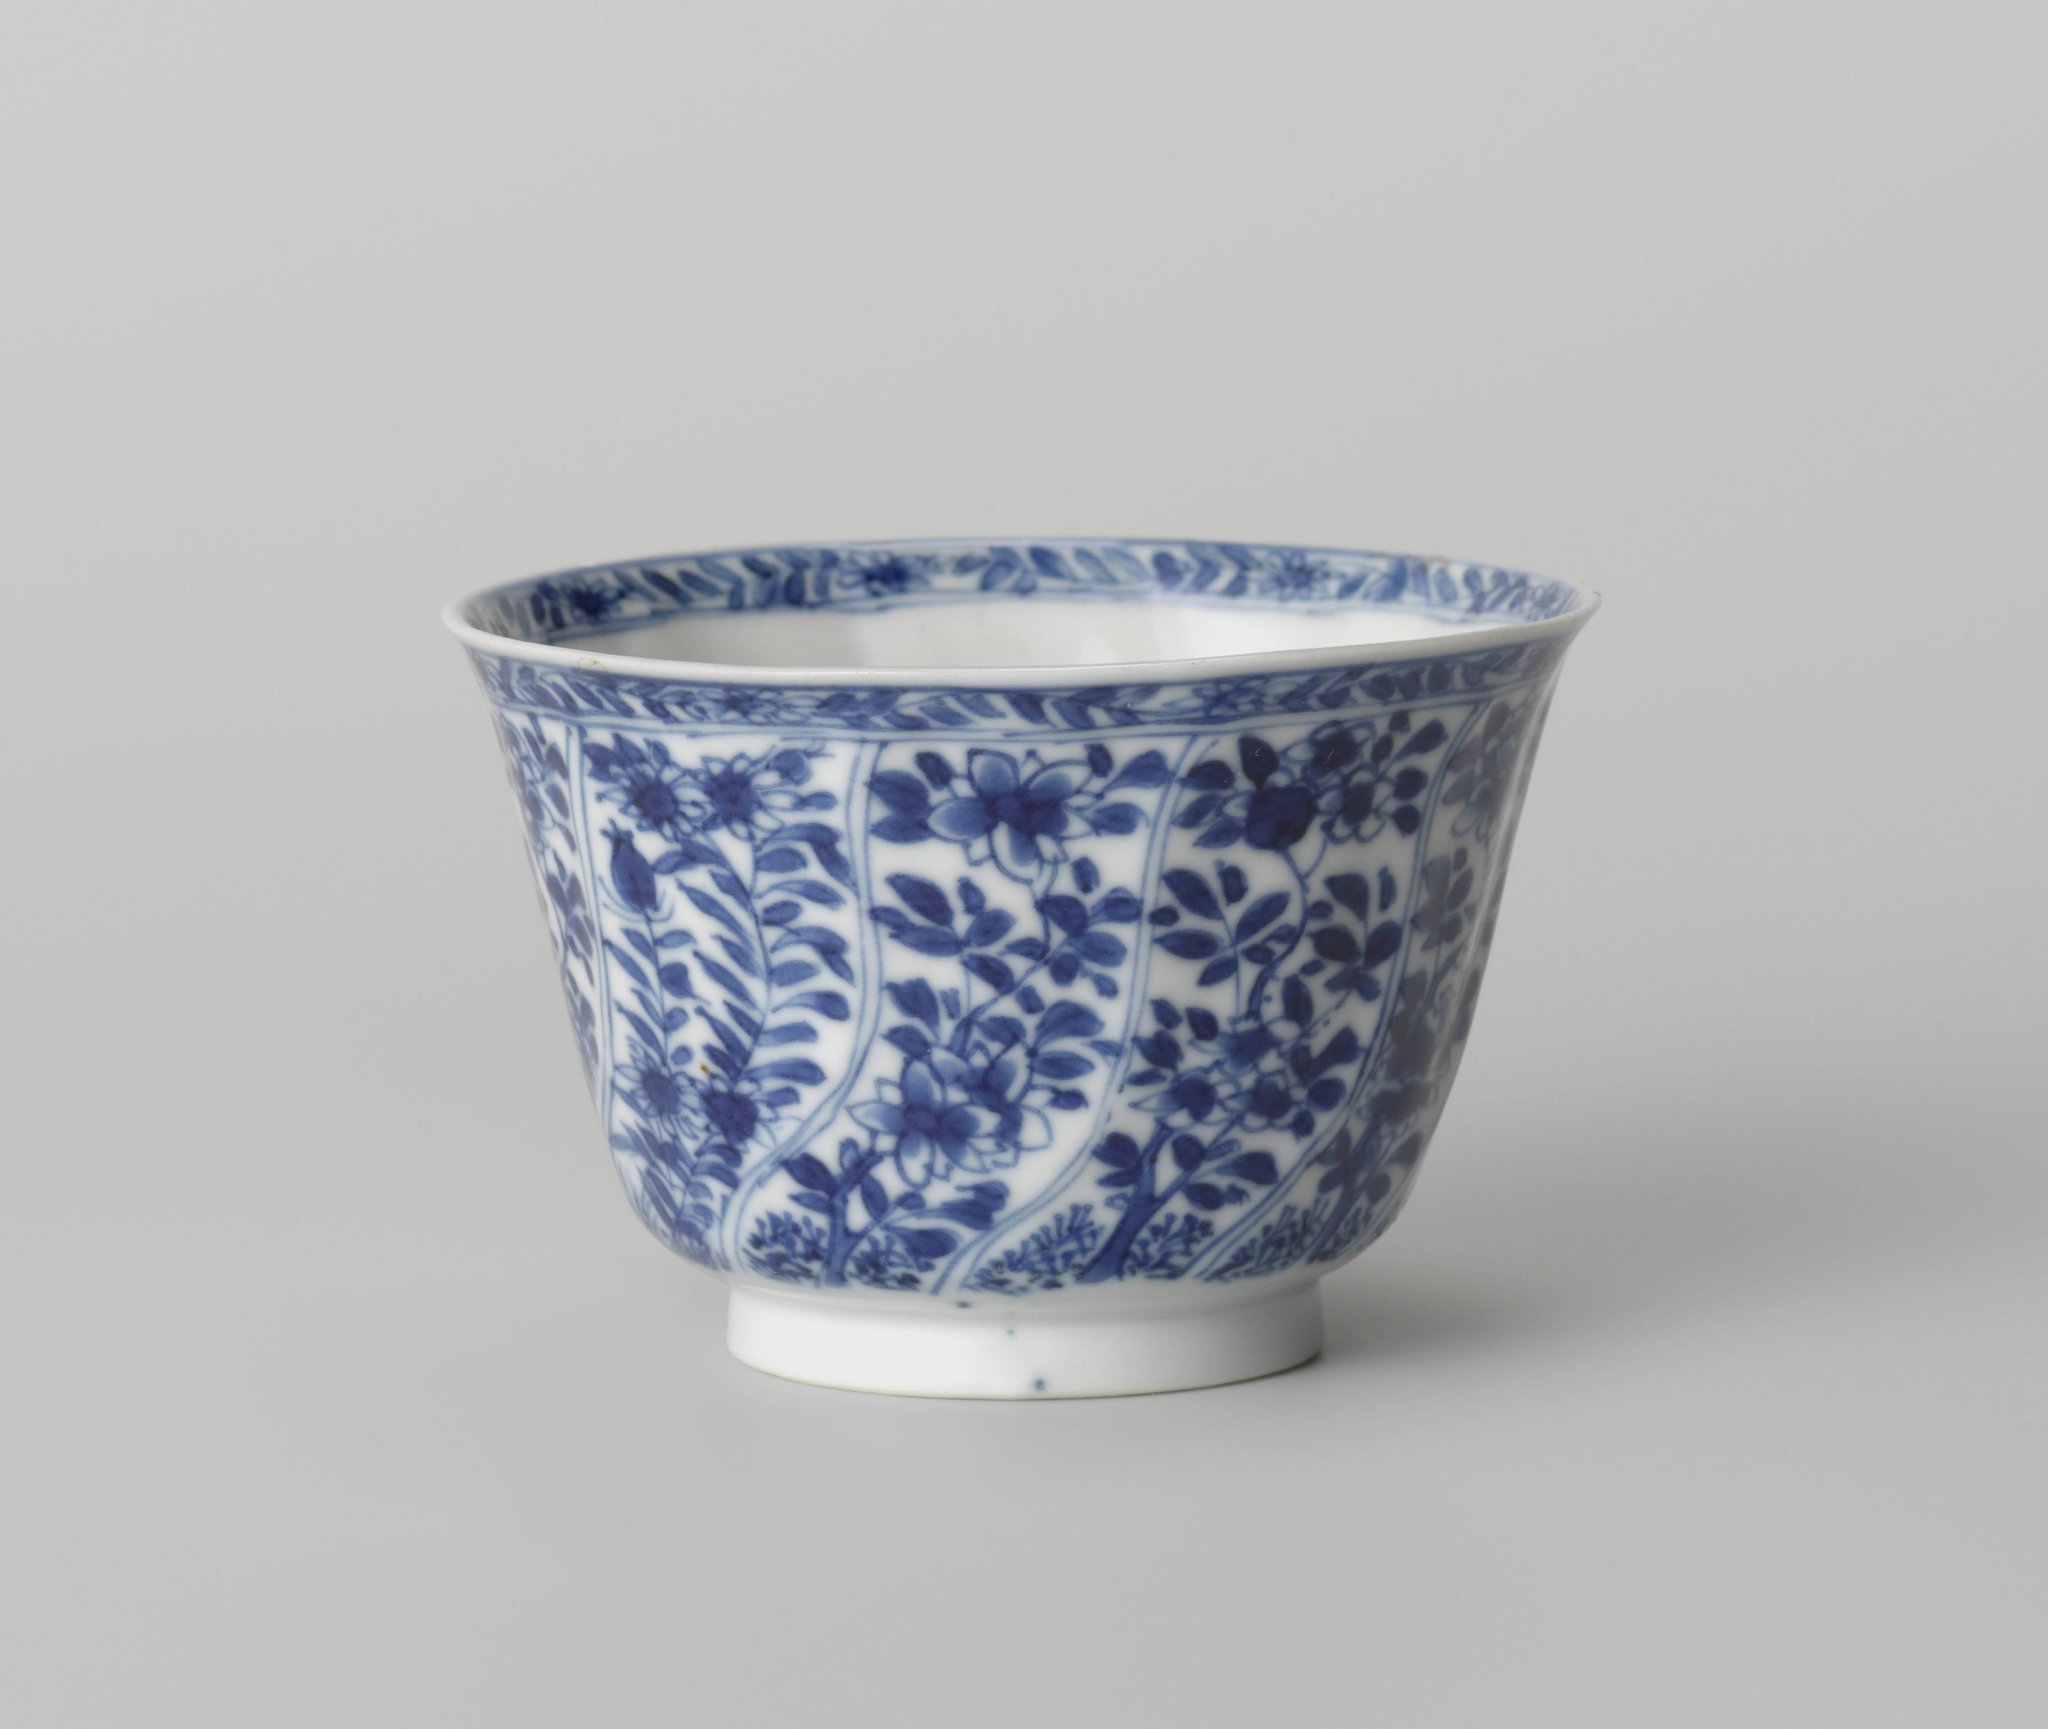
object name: cup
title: Cup with twisted panels with flower sprays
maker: Anonymous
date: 1680-1720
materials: cobalt, glaze, paint, porcelain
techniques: firing, forming, turning, vitrification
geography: china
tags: ornament derived from plant forms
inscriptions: mark: ‘福’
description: Kop van porselein, getorst, beschilderd in onderglazuurblauw met bloemtakken. Langs binnen- en de buitenzijde van de mondrand gestileerde bloem- en bladslingers. Op de bodem, binnen een dubbele cirkel, een bloem op stengel met bladeren. Gemerkt Jade in dubbele ring.